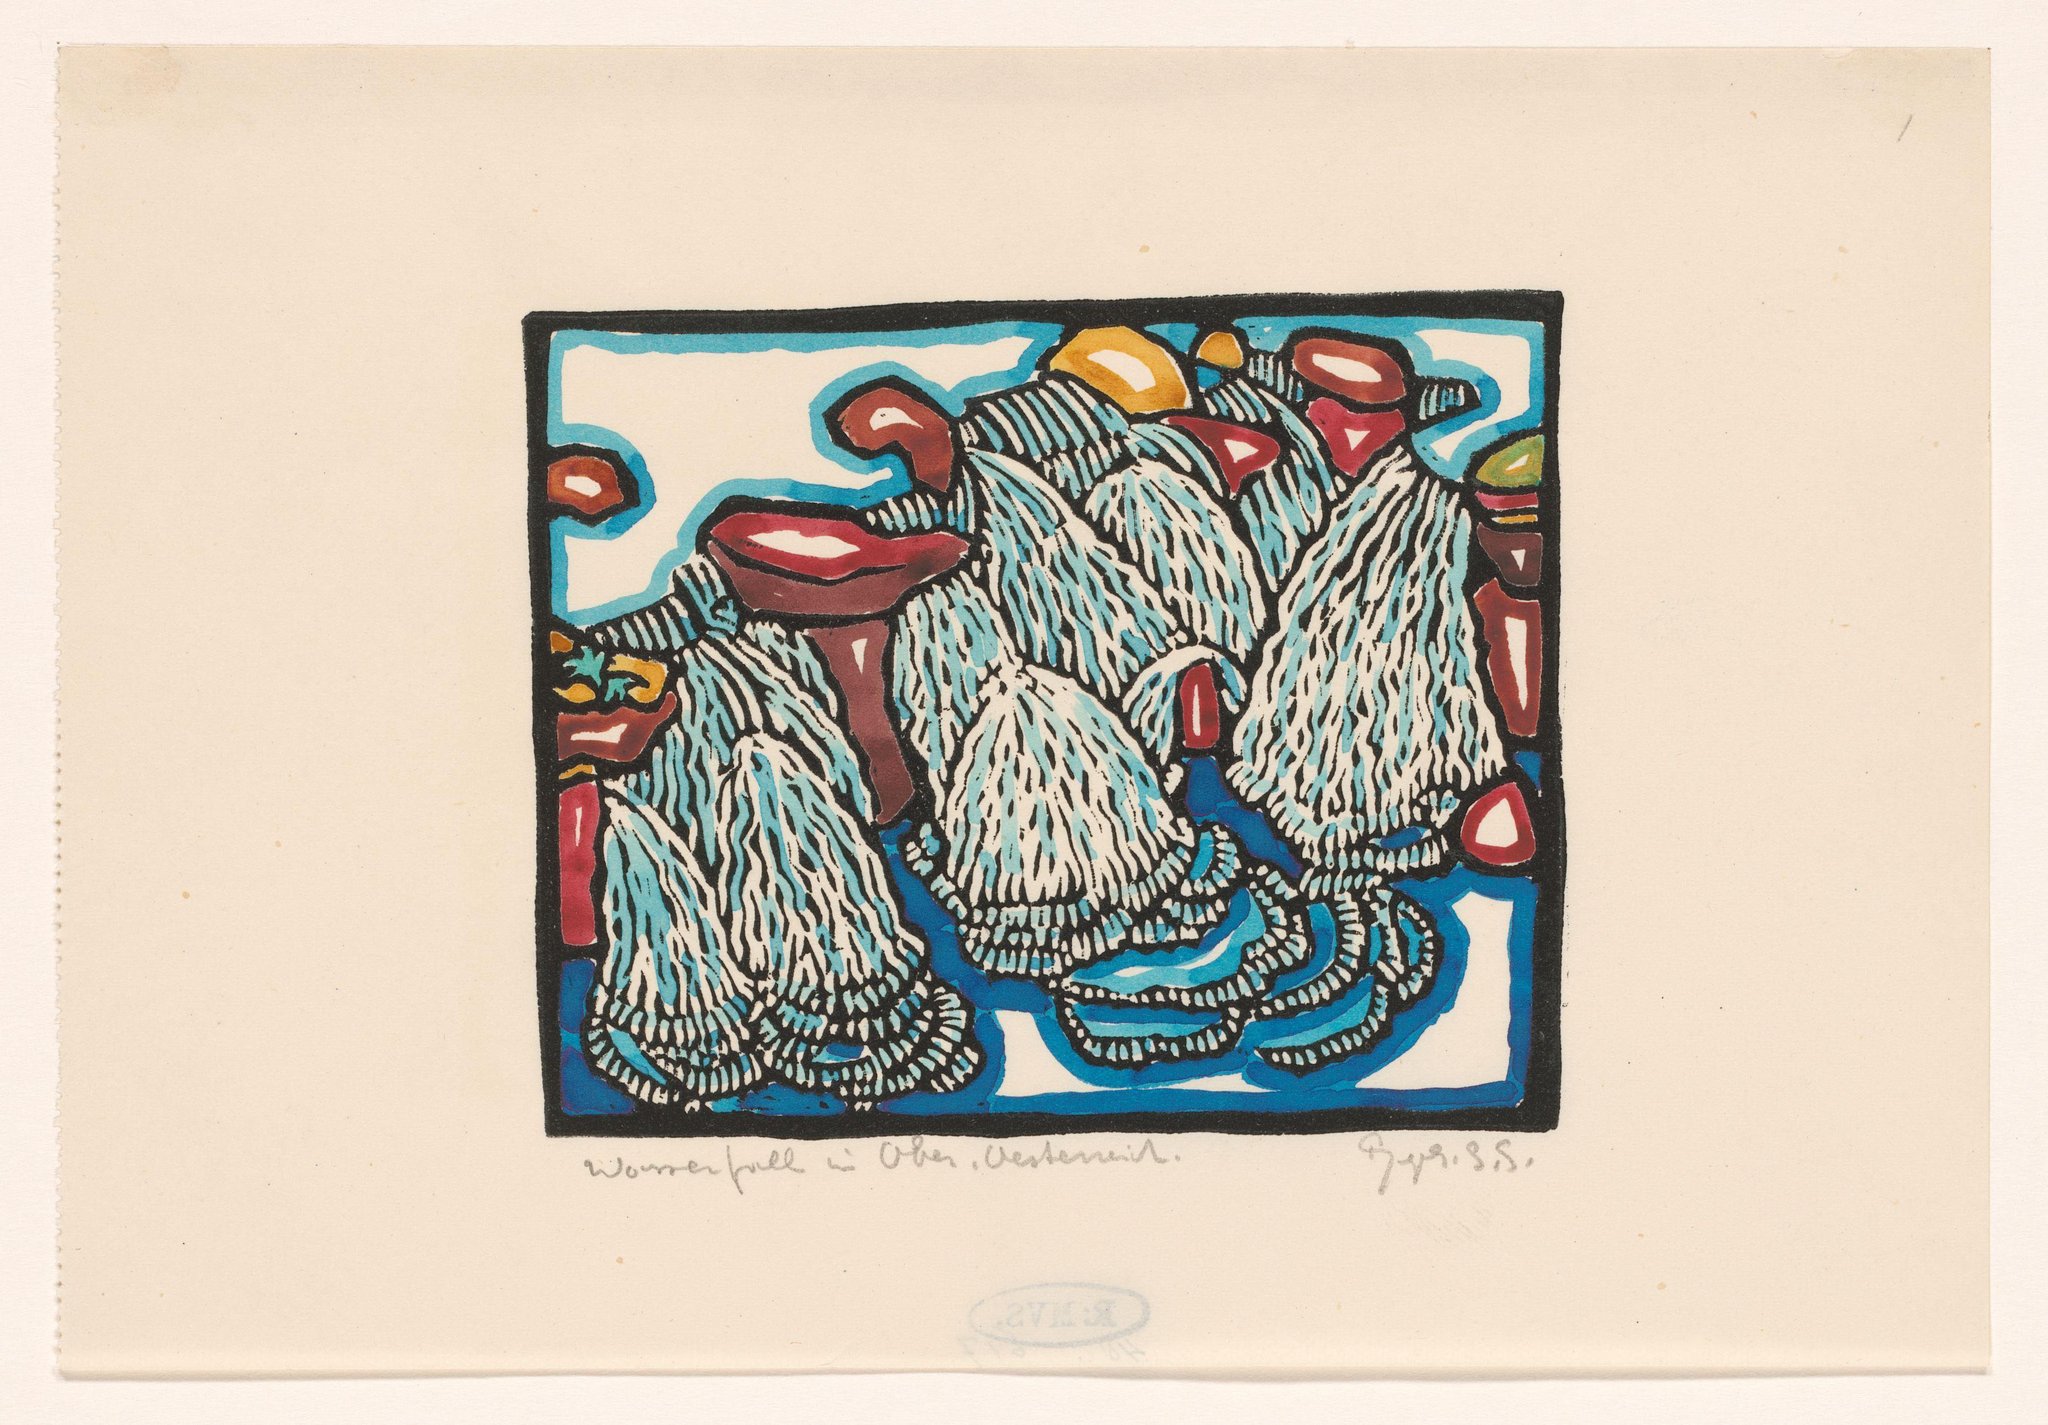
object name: print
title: Wasserfall in Ober-Oesterreich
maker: reijer stolk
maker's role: draughtsman, print maker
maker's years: 1896-1945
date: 1906-1945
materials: paper, watercolor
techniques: hand coloring, linocut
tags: waterfall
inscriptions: collector's mark: Lugt 2228